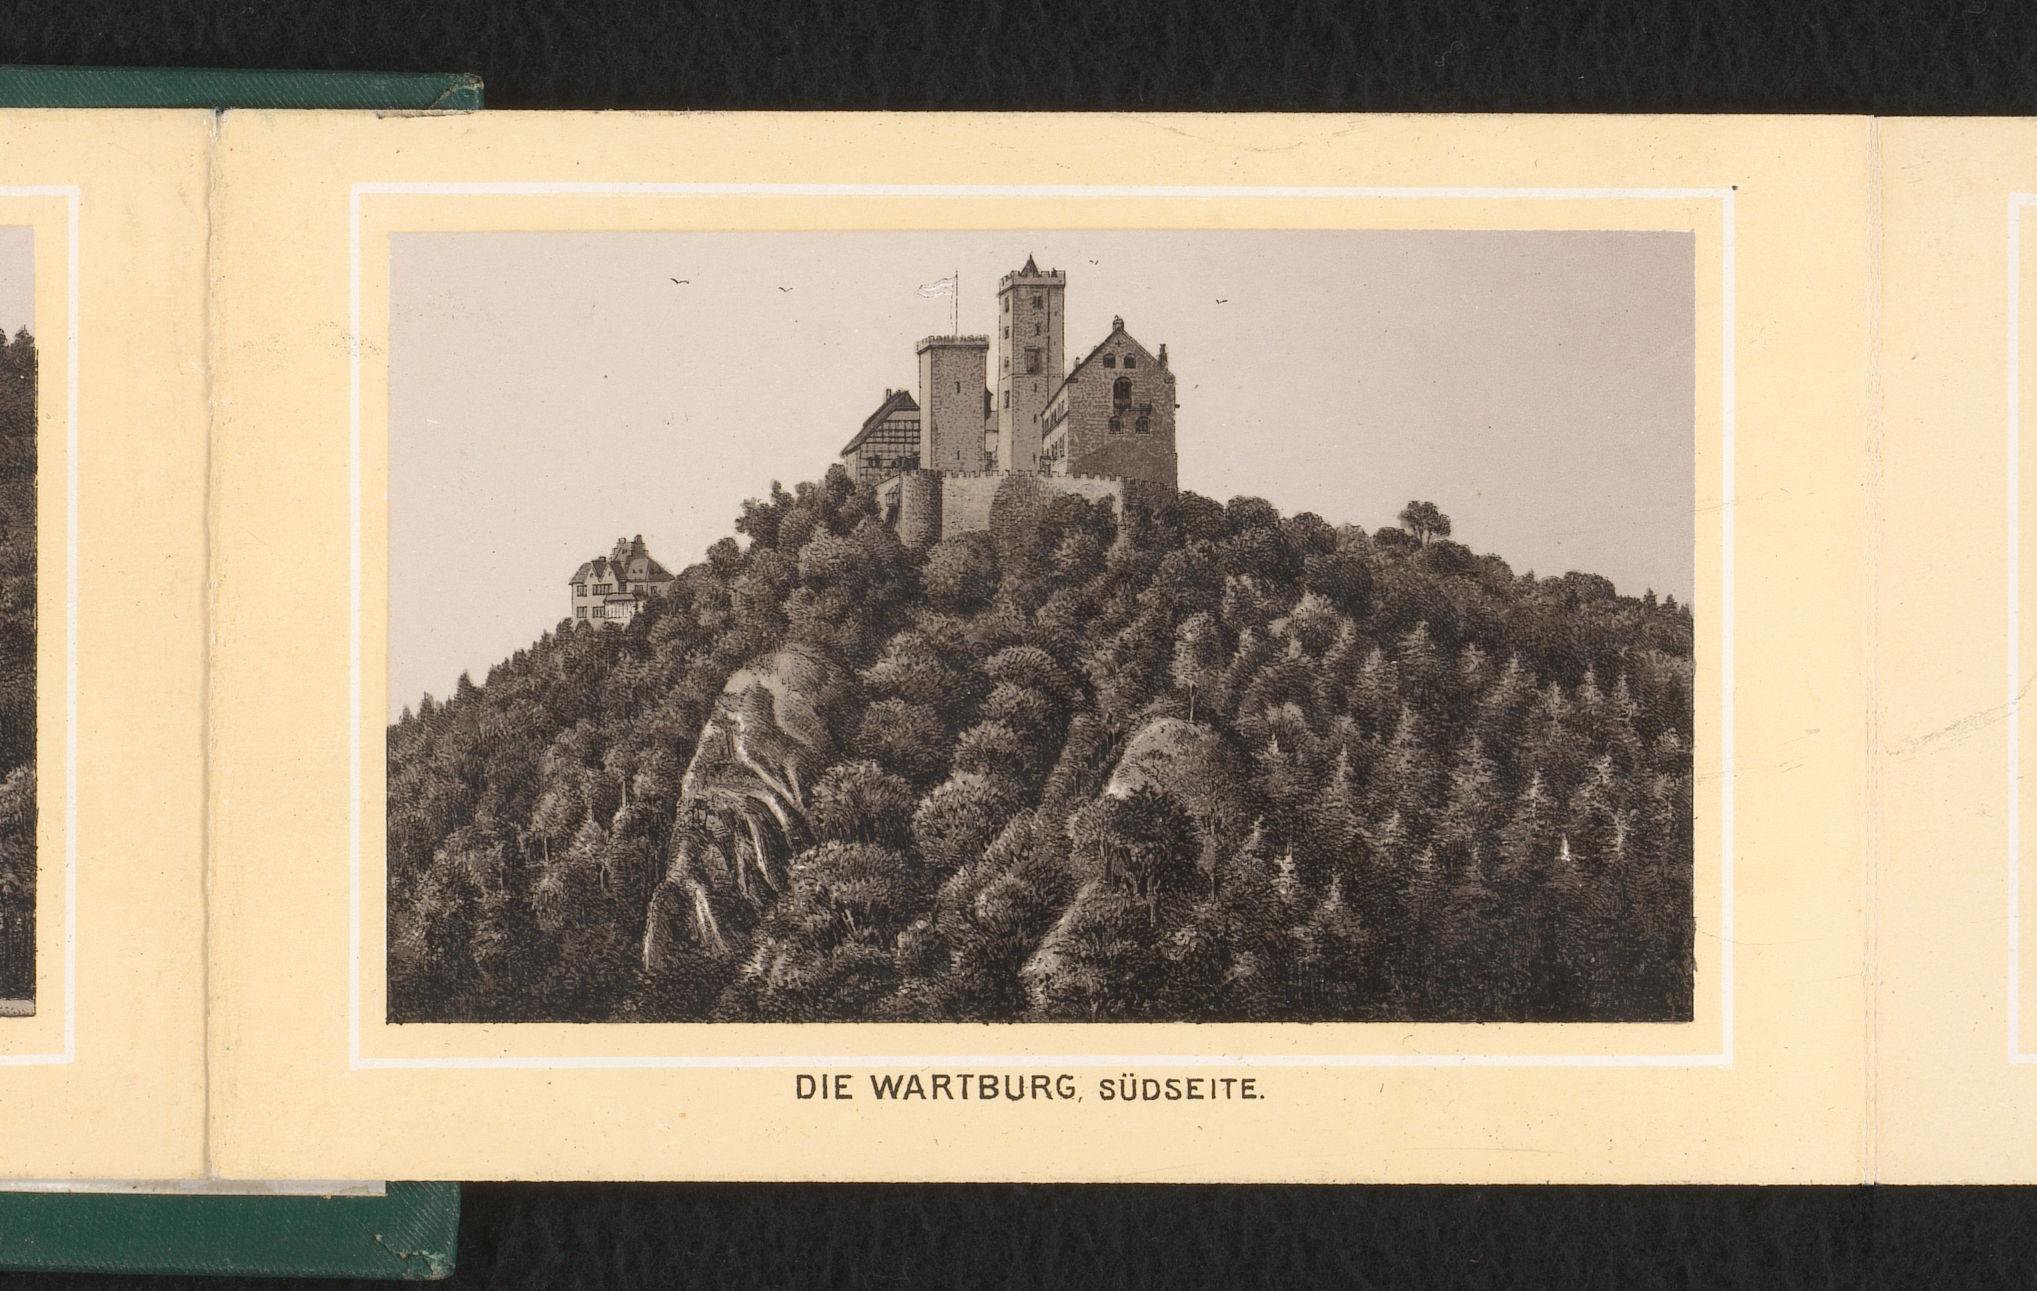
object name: ansichtkaart, prentbriefkaart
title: Die Wartburg, Südseite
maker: louis glaser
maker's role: printer, publisher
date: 1874-1900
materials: cardboard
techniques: photolithography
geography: leipzig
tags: castle, mountains